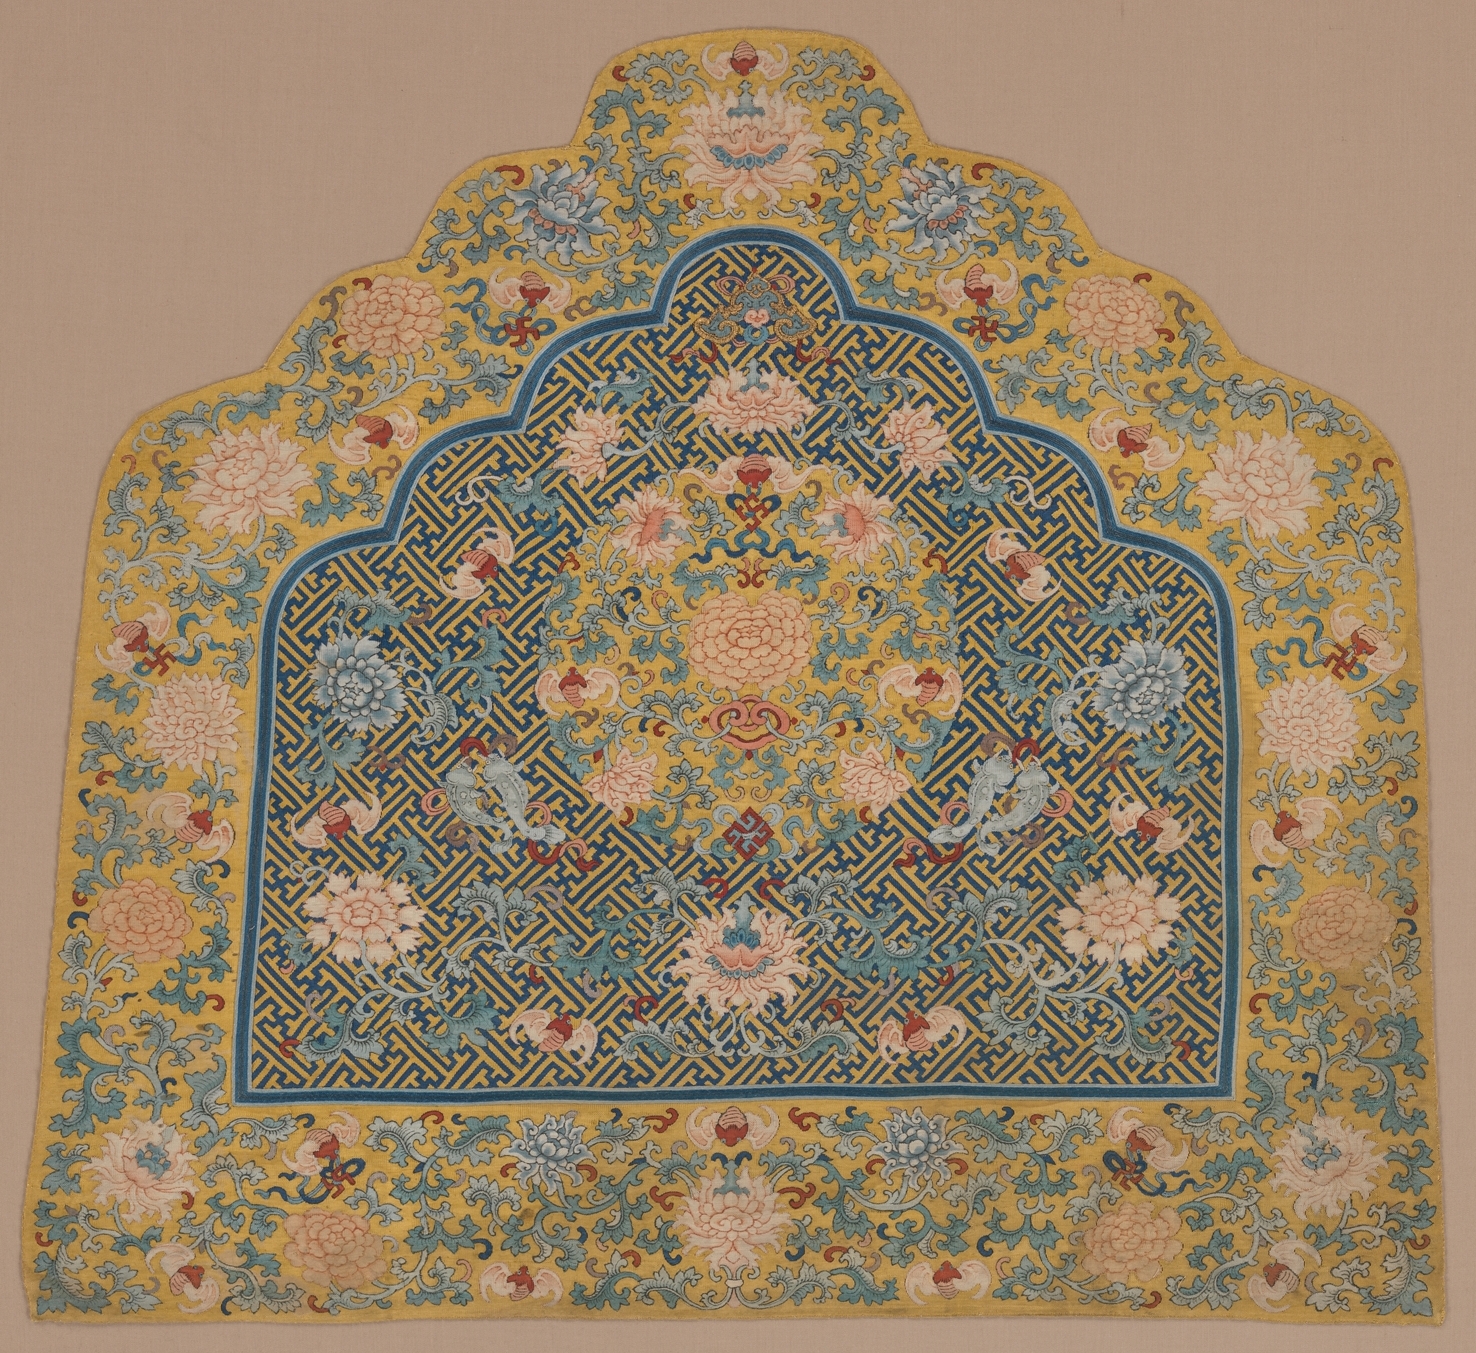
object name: pillow cover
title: Back Rest Cover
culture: chinese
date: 1801-1900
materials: ink, silk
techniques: tapestry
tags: flowers